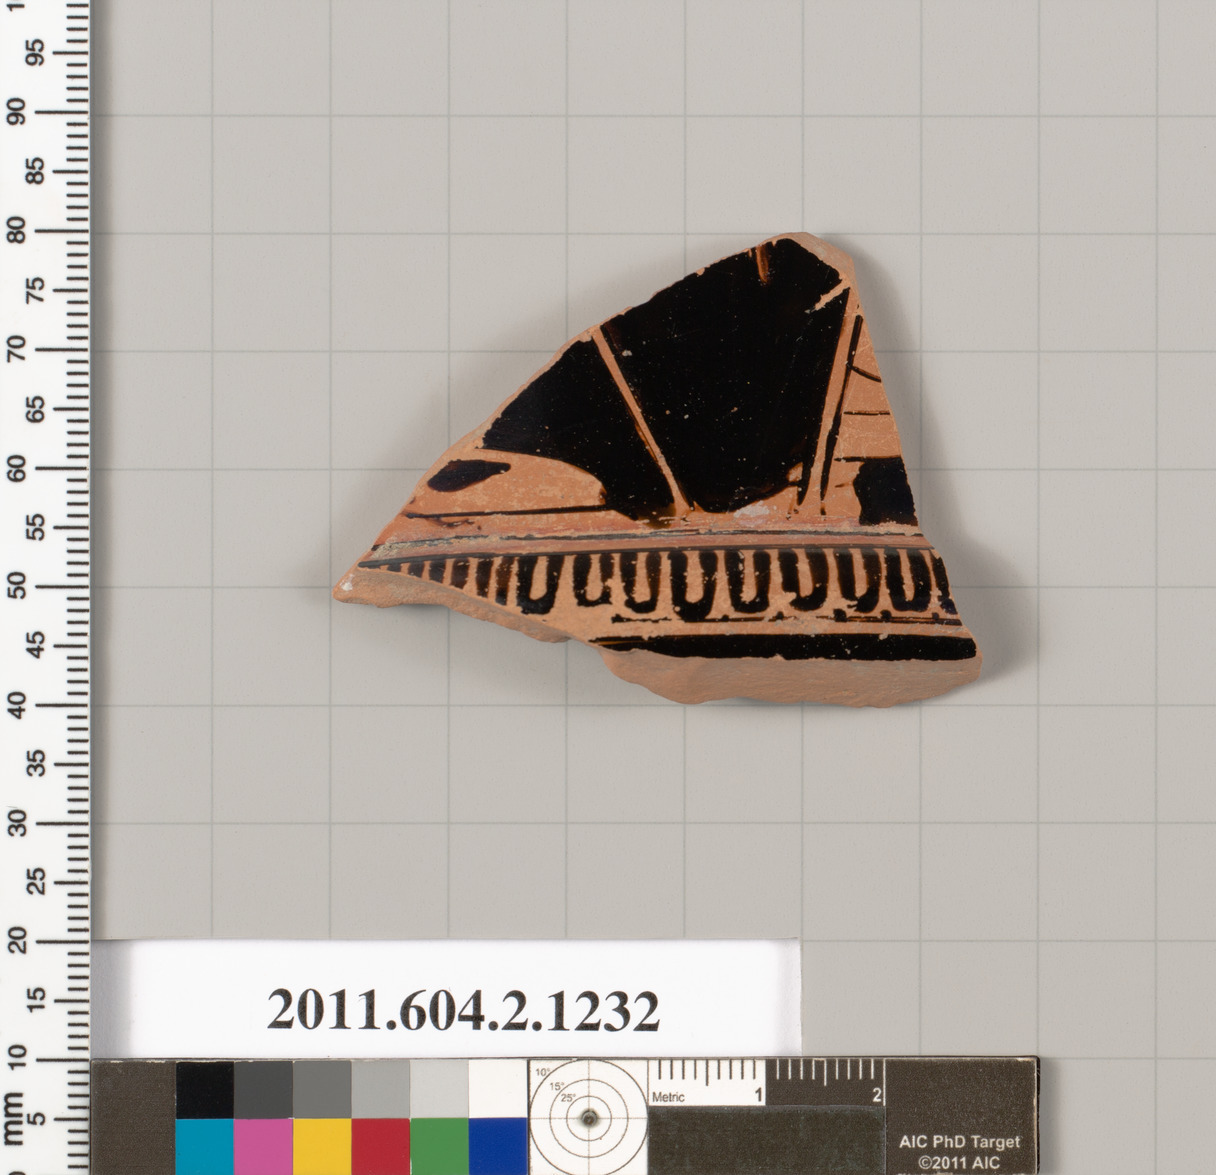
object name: rhyton fragment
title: Terracotta rhyton (vase for libations or drinking)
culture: greek, attic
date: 475-451 BCE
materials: terracotta